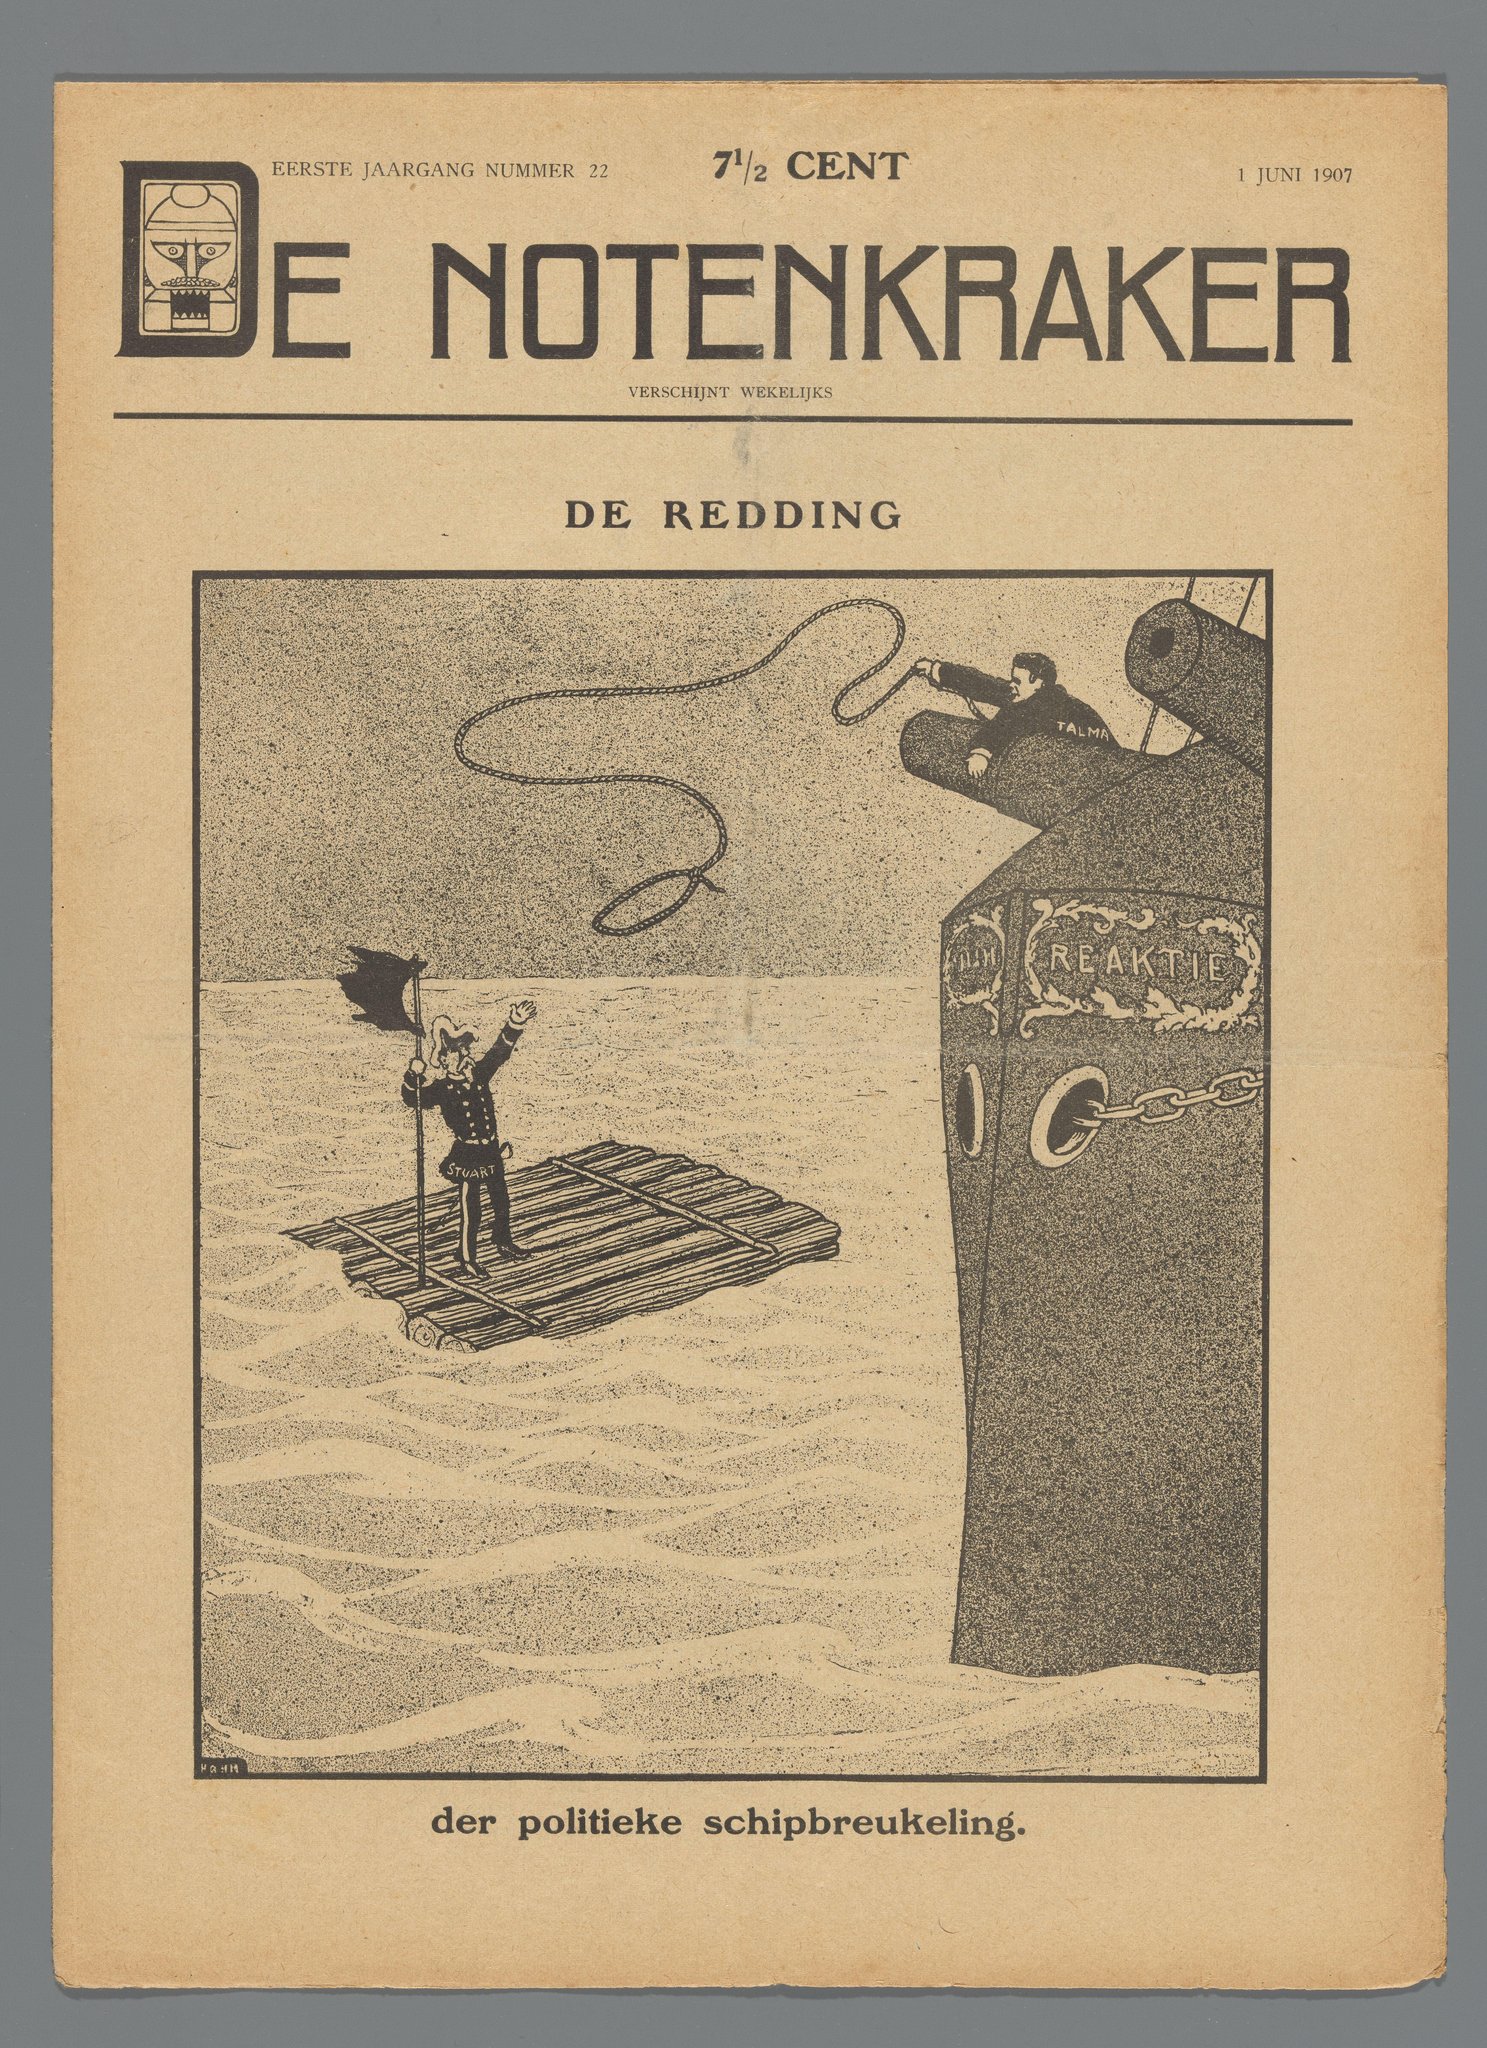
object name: magazine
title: De Notenkraker, 1 juni 1907 / De redding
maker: albert hahn (i)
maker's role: draughtsman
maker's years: 1877-1918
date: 1907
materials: paper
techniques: lithograph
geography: amsterdam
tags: politician, life-saving service, political caricatures and satires, netherlands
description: Aflevering van het satirische tijdschrift De Notenkraker van 1 juni 1907, eerste jaargang, nummer 22. Omslag met illustratie van Syb Talma die vanaf het schip 'Reaktie' een reddingslijn uitwerpt naar minister van Marine William Cohen Stuart, als schipbreukeling op een vlot. Onderdeel van een volledige eerste jaargang (1907). Elk nummer bevat 8 bladzijden, deels nog niet losgesneden, met op de voorzijde steeds een spotprent van Albert Hahn, op de overige pagina's prenten van Hahn steeds tussen de tekst. In de letter 'D' van de titel is een kop van een zgn. notenkraker afgebeeld.